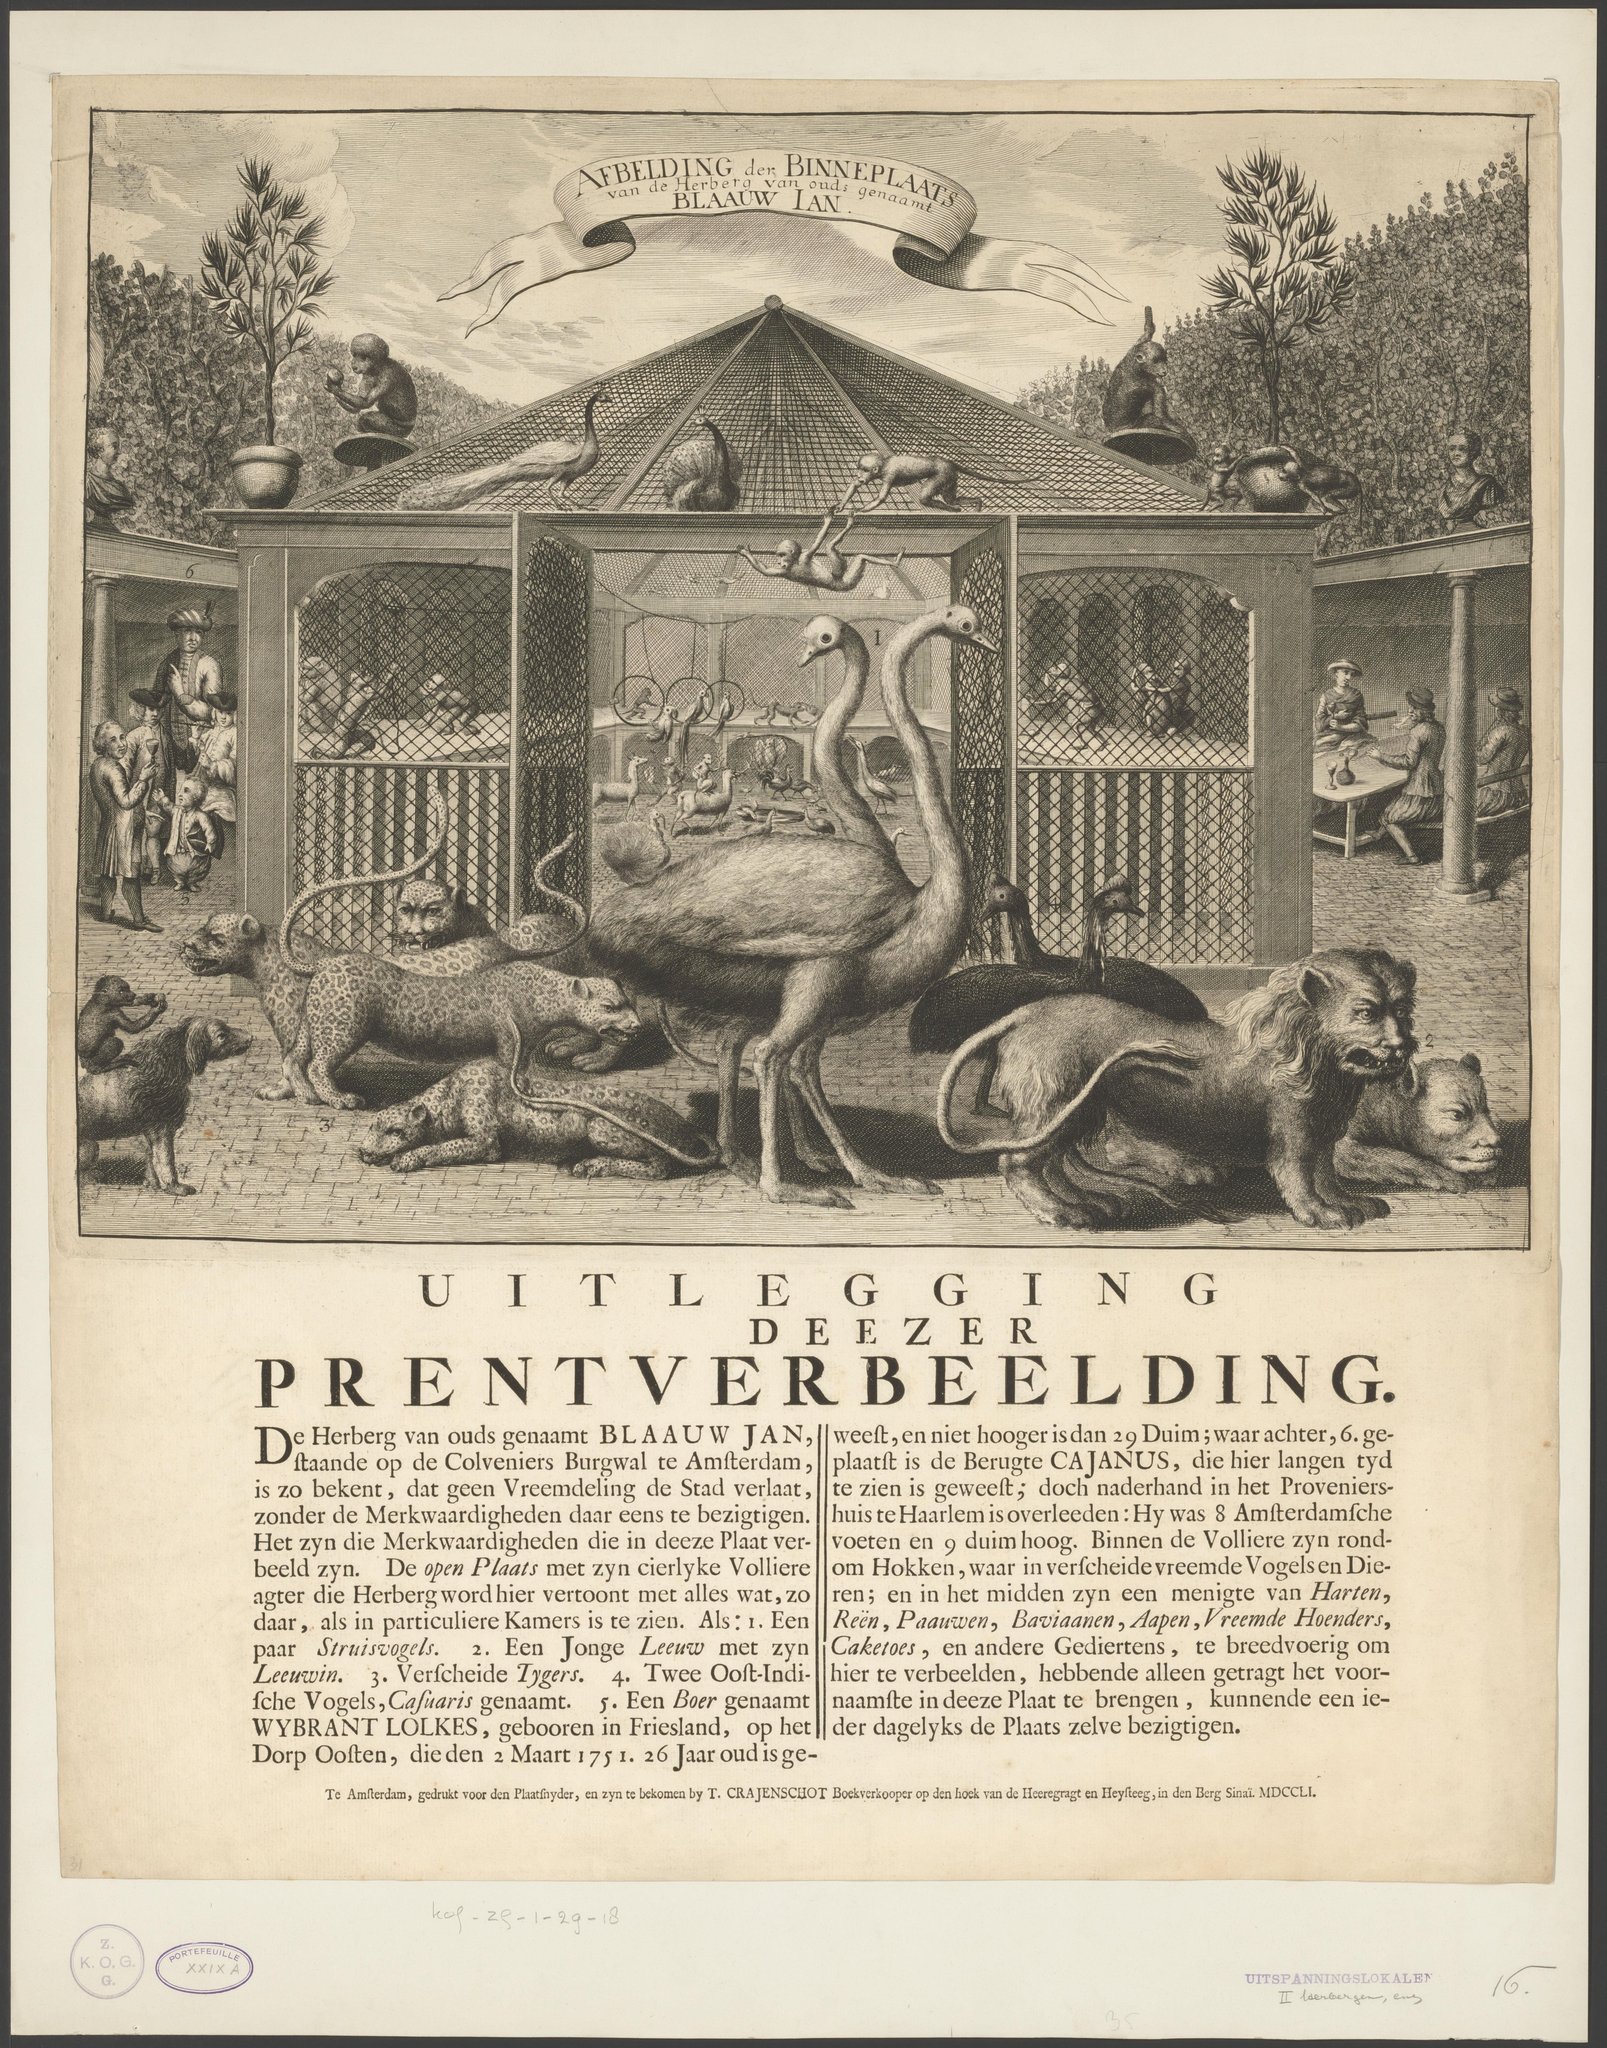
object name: text sheet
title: Menagerie van Blaauw Jan, 1751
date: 1751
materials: paper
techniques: engraving, etching, letterpress printing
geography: amsterdam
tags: birds in a large cage, aviary, little people, zoological garden, zoo, seen as place where non-domestic animals are kept, (human) skeleton - aa - female human figure, zoo (as place of recreation)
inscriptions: stamp, stamp, collector's mark: Lugt 1641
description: Menagerie op de binnenplaats van de herberg van Jan Berentsz Westerhof of Blaauw Jan op de Kloveniersburgwal te Amsterdam in 1751: een hof met in het midden een volière met struisvogels, pauwen, kasuarissen, papegaaien en een raaf. Op de voorgrond een leeuw, panters, apen en een jonge walrus. Volgens de uitleg bij de prent waren deze dieren, evenals de Friese kleine mens Wybren Lolkes en de Finse reus Daniel Cajanus, hier ook te bewonderen. Onderwerpsrubrieken binnen de Atlas Zeden en Gewoonten: Zeden en gewoonten in engeren zin, Volksleven, Uitspanningslokalen, Herbergen.